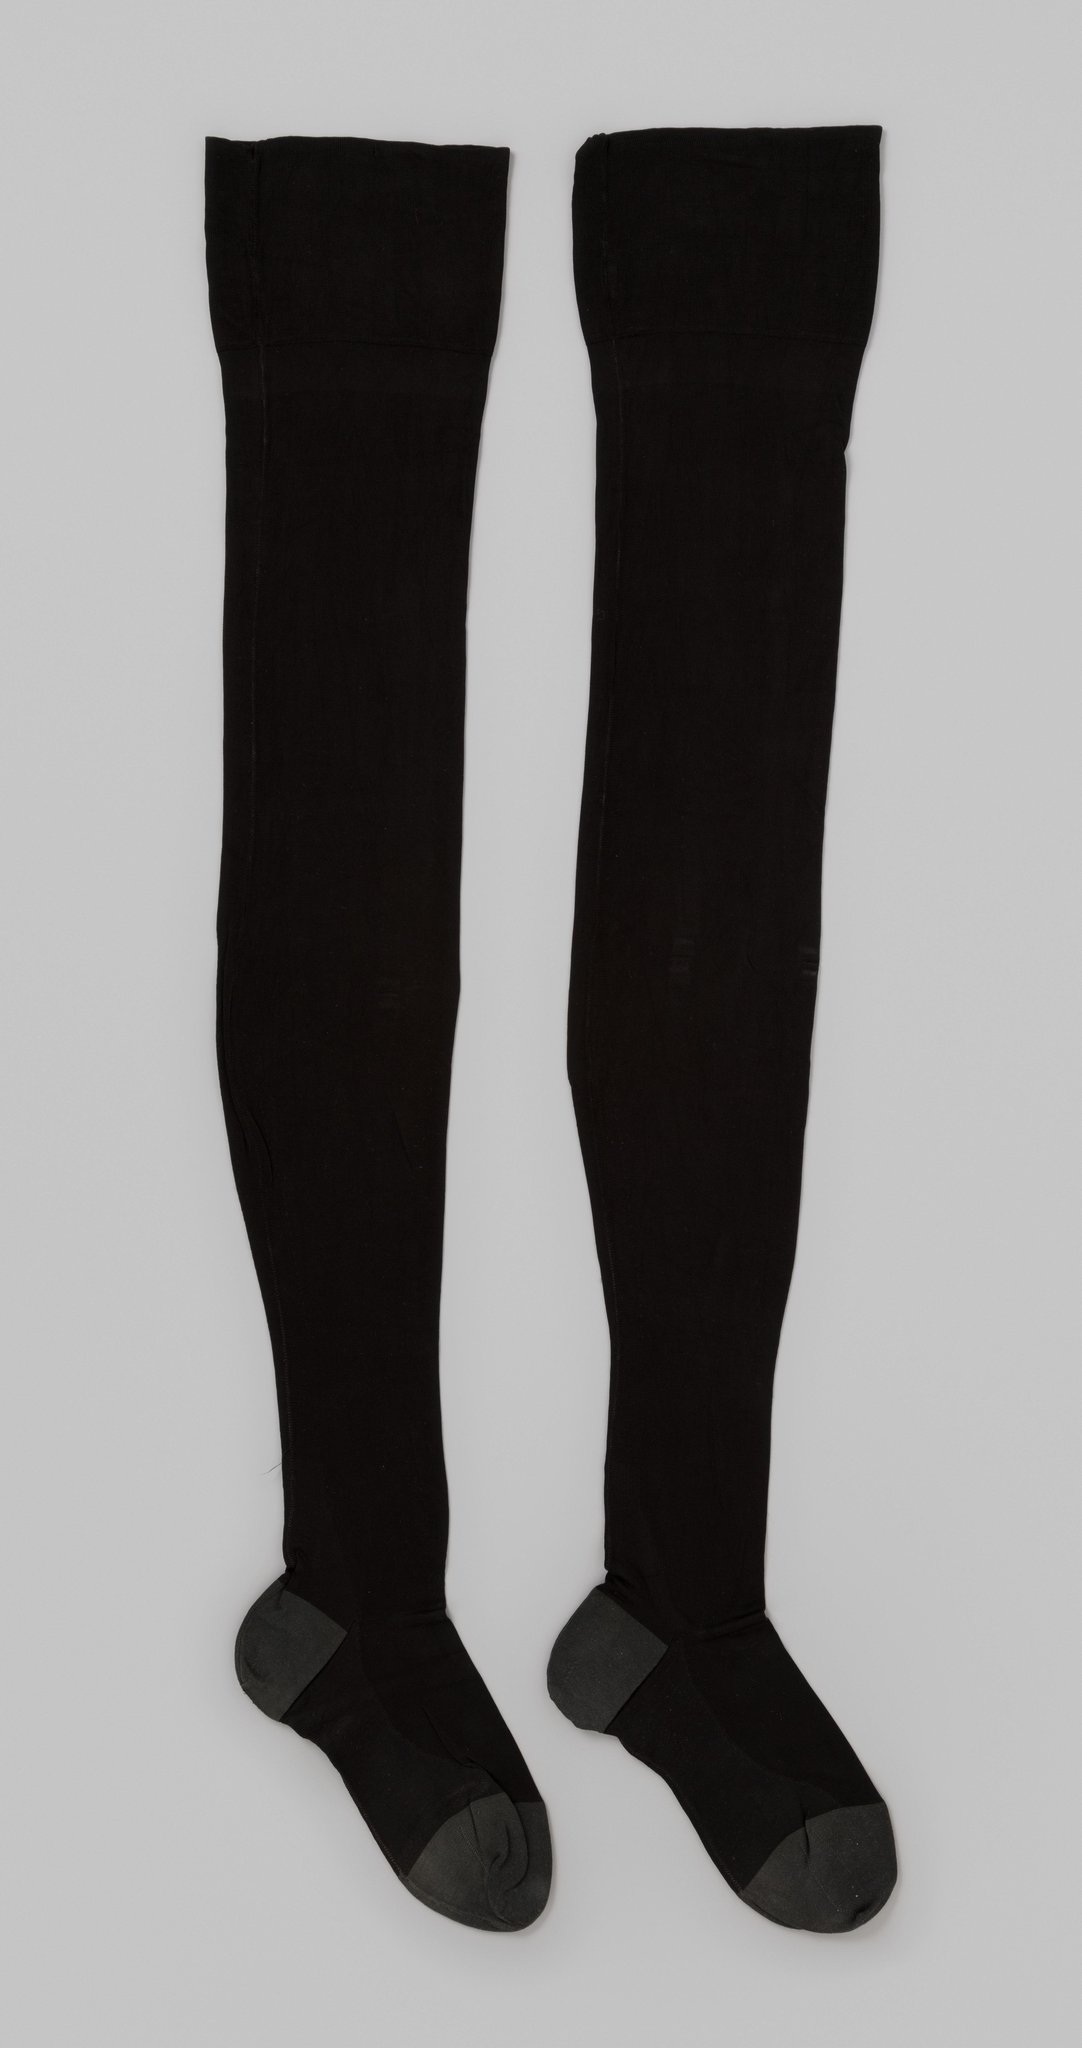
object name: clothing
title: Kous van effen zwarte zijden tricot met katoenen hiel en teen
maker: Anonymous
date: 1915-1935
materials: cotton, silk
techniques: knitting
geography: netherlands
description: Vijf paar zwarte kousen van zijde. Vijf paar zwarte kousen van zijde. Alle verschillend, alle van dikke tricot. Alle met naad en hiel. Brede verschillende boorden; enkele van katoen. Eén paar heeft een enkel-pijl, de klink.